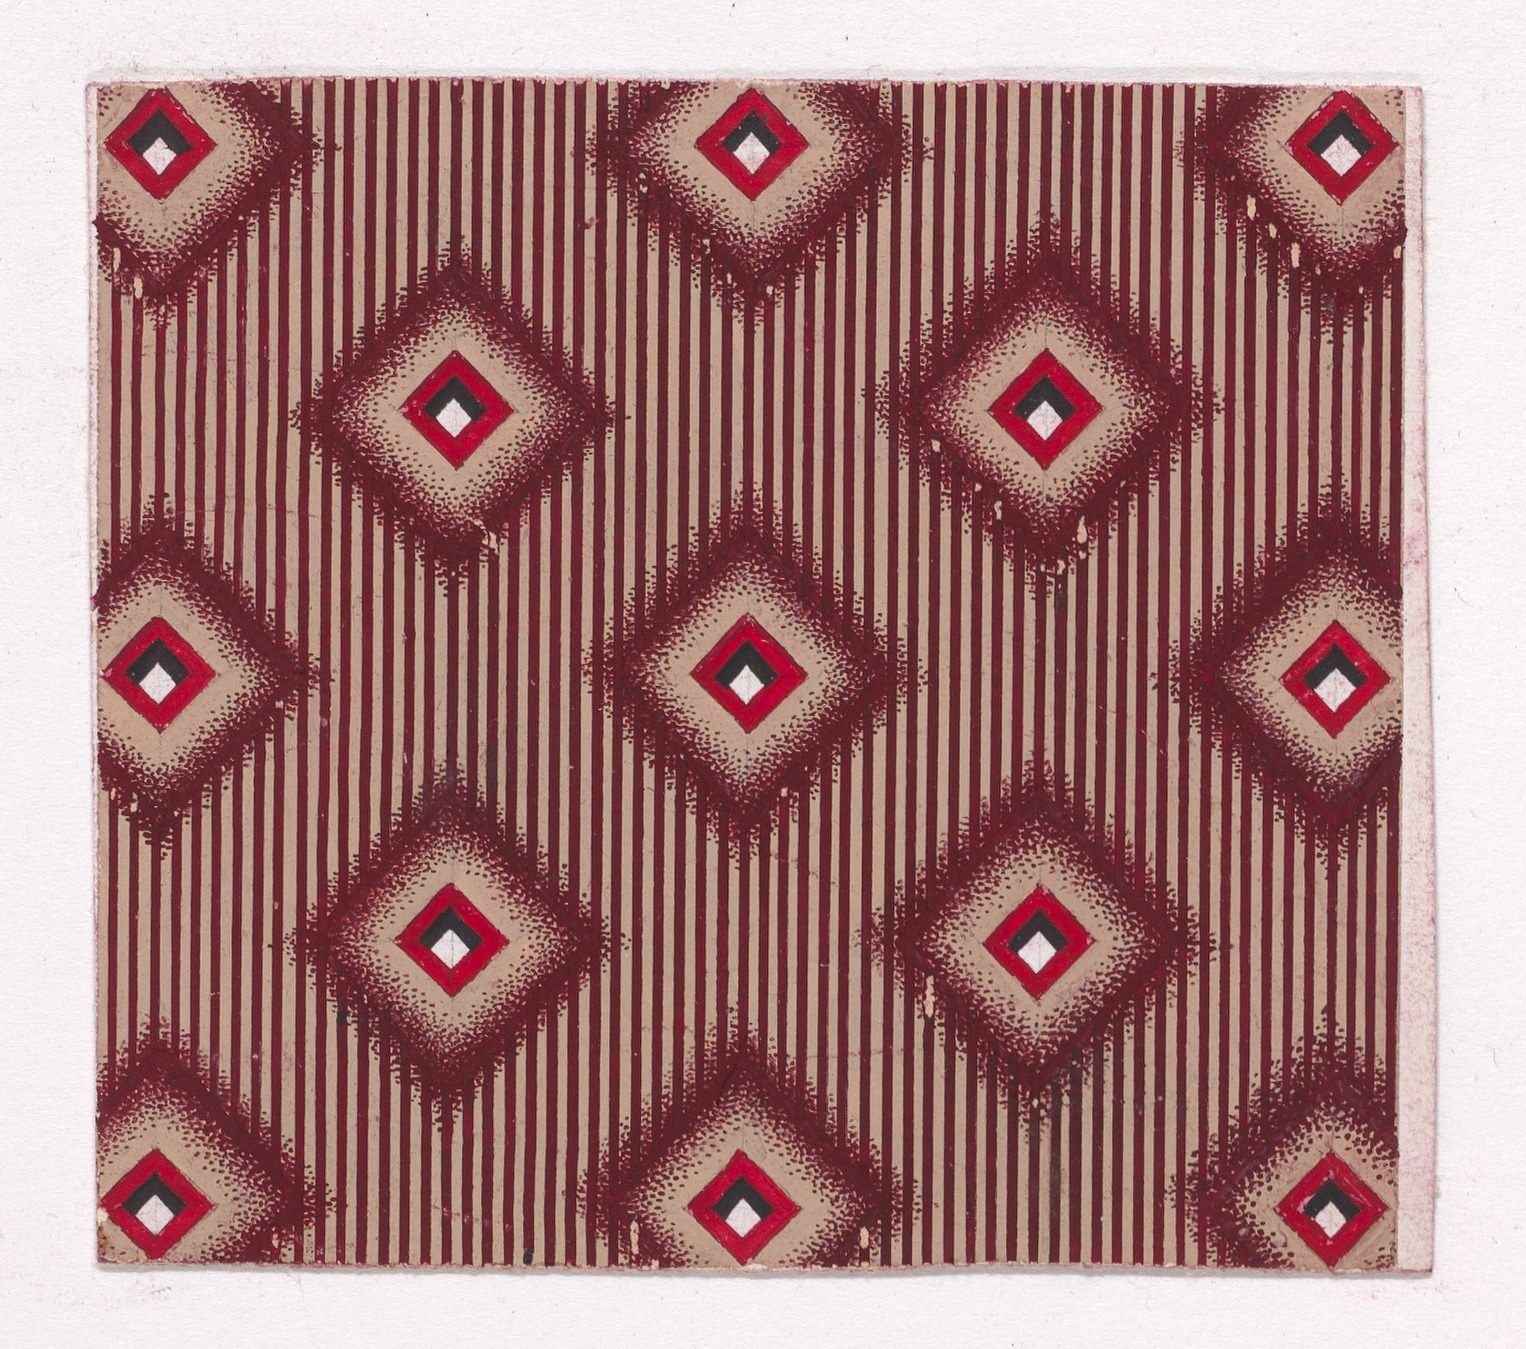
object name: drawing ornament architecture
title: Textile Design with Alternating Lozenges over a Striped Background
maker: anonymous, alsatian, 19th century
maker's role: artist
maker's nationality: alsatian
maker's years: 1800-1900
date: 1840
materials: gouache